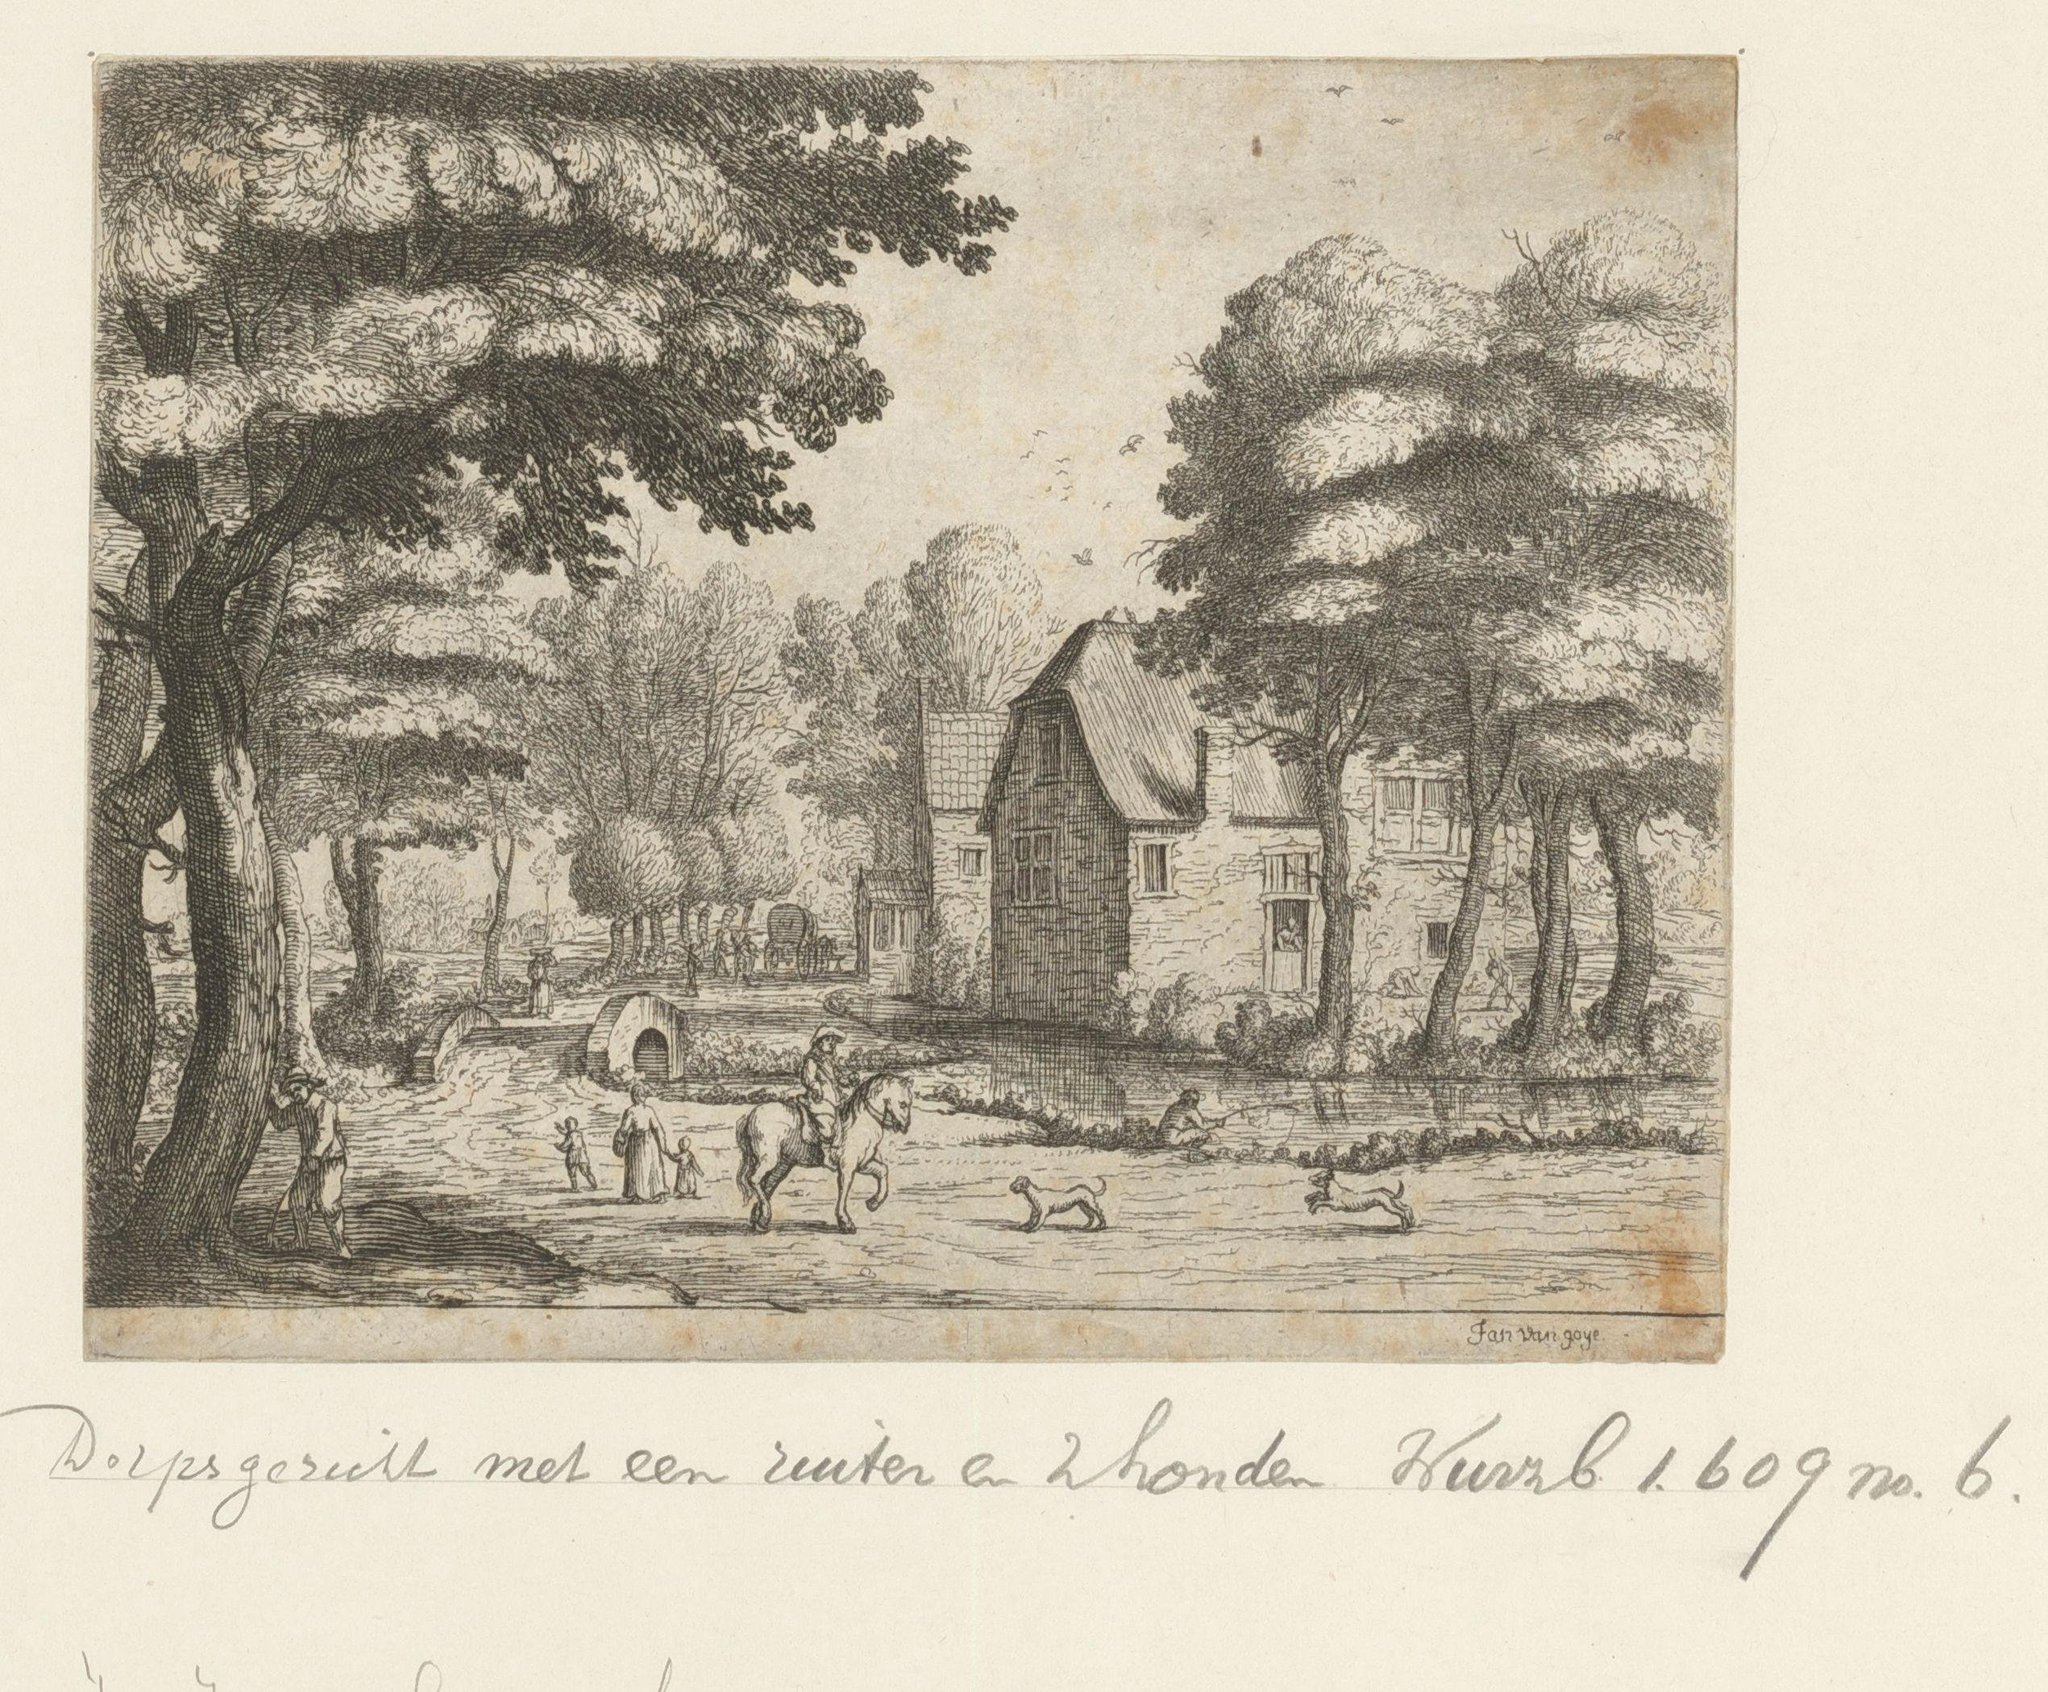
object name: print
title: Landschappen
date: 1726-1799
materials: paper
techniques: etching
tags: riding a horse, ass, or mule; rider, horseman, landscape with bridge, viaduct or aqueduct, dog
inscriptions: collector's mark: Lugt 1641, stamp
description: Onderwerpsrubrieken binnen de Atlas Zeden en Gewoonten: Handel, nijverheid en verkeer, Buitenleven.